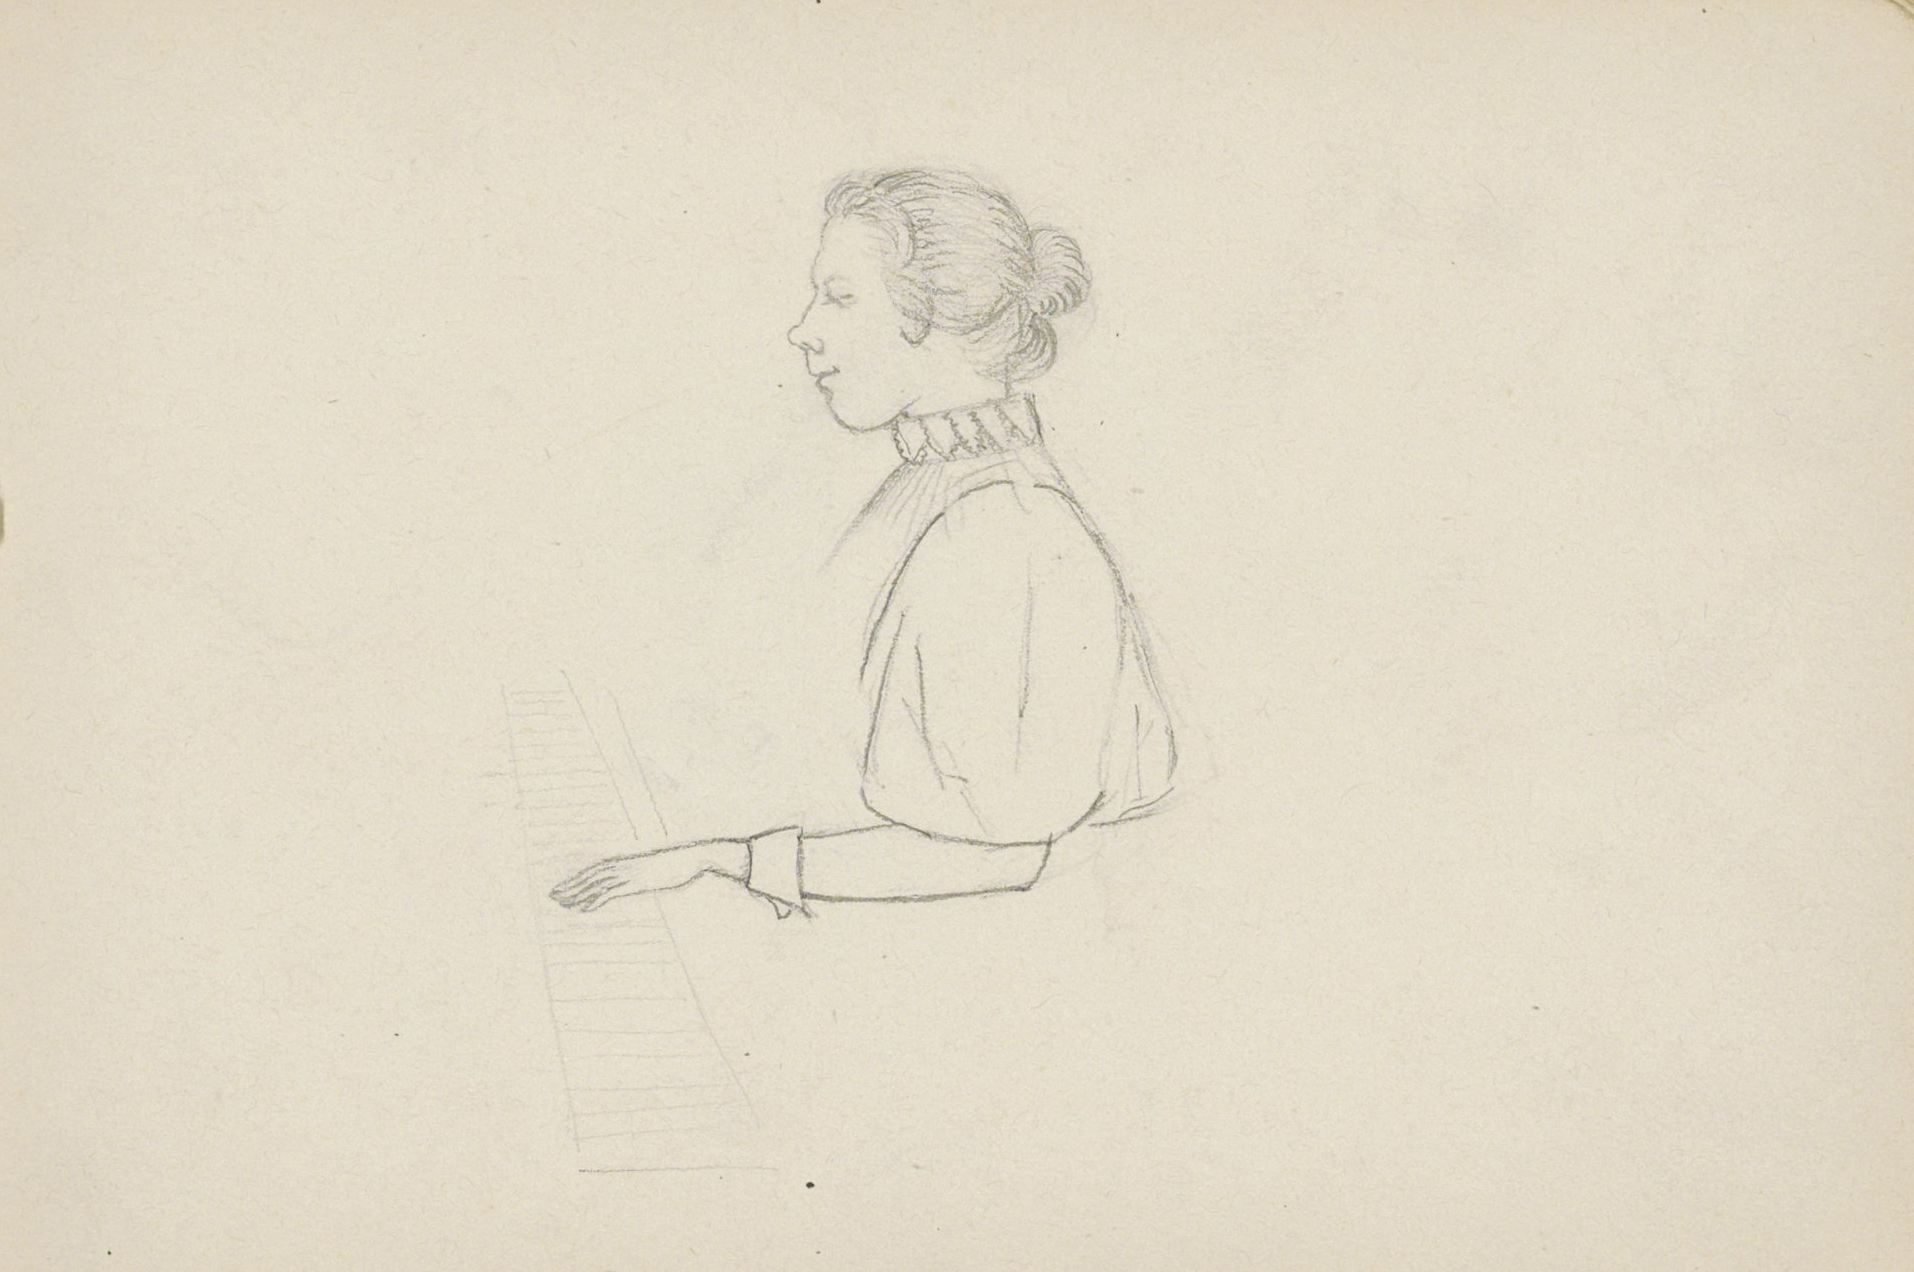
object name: sketchbook leaf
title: Vrouw die met de linkerhand piano speelt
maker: julie de graag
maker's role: draughtsman, print maker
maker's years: 1877-1924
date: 1894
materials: paper, pencil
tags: one person playing keyboard instrument, adult woman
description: Blad 22 recto uit een schetsboek met 35 bladen.